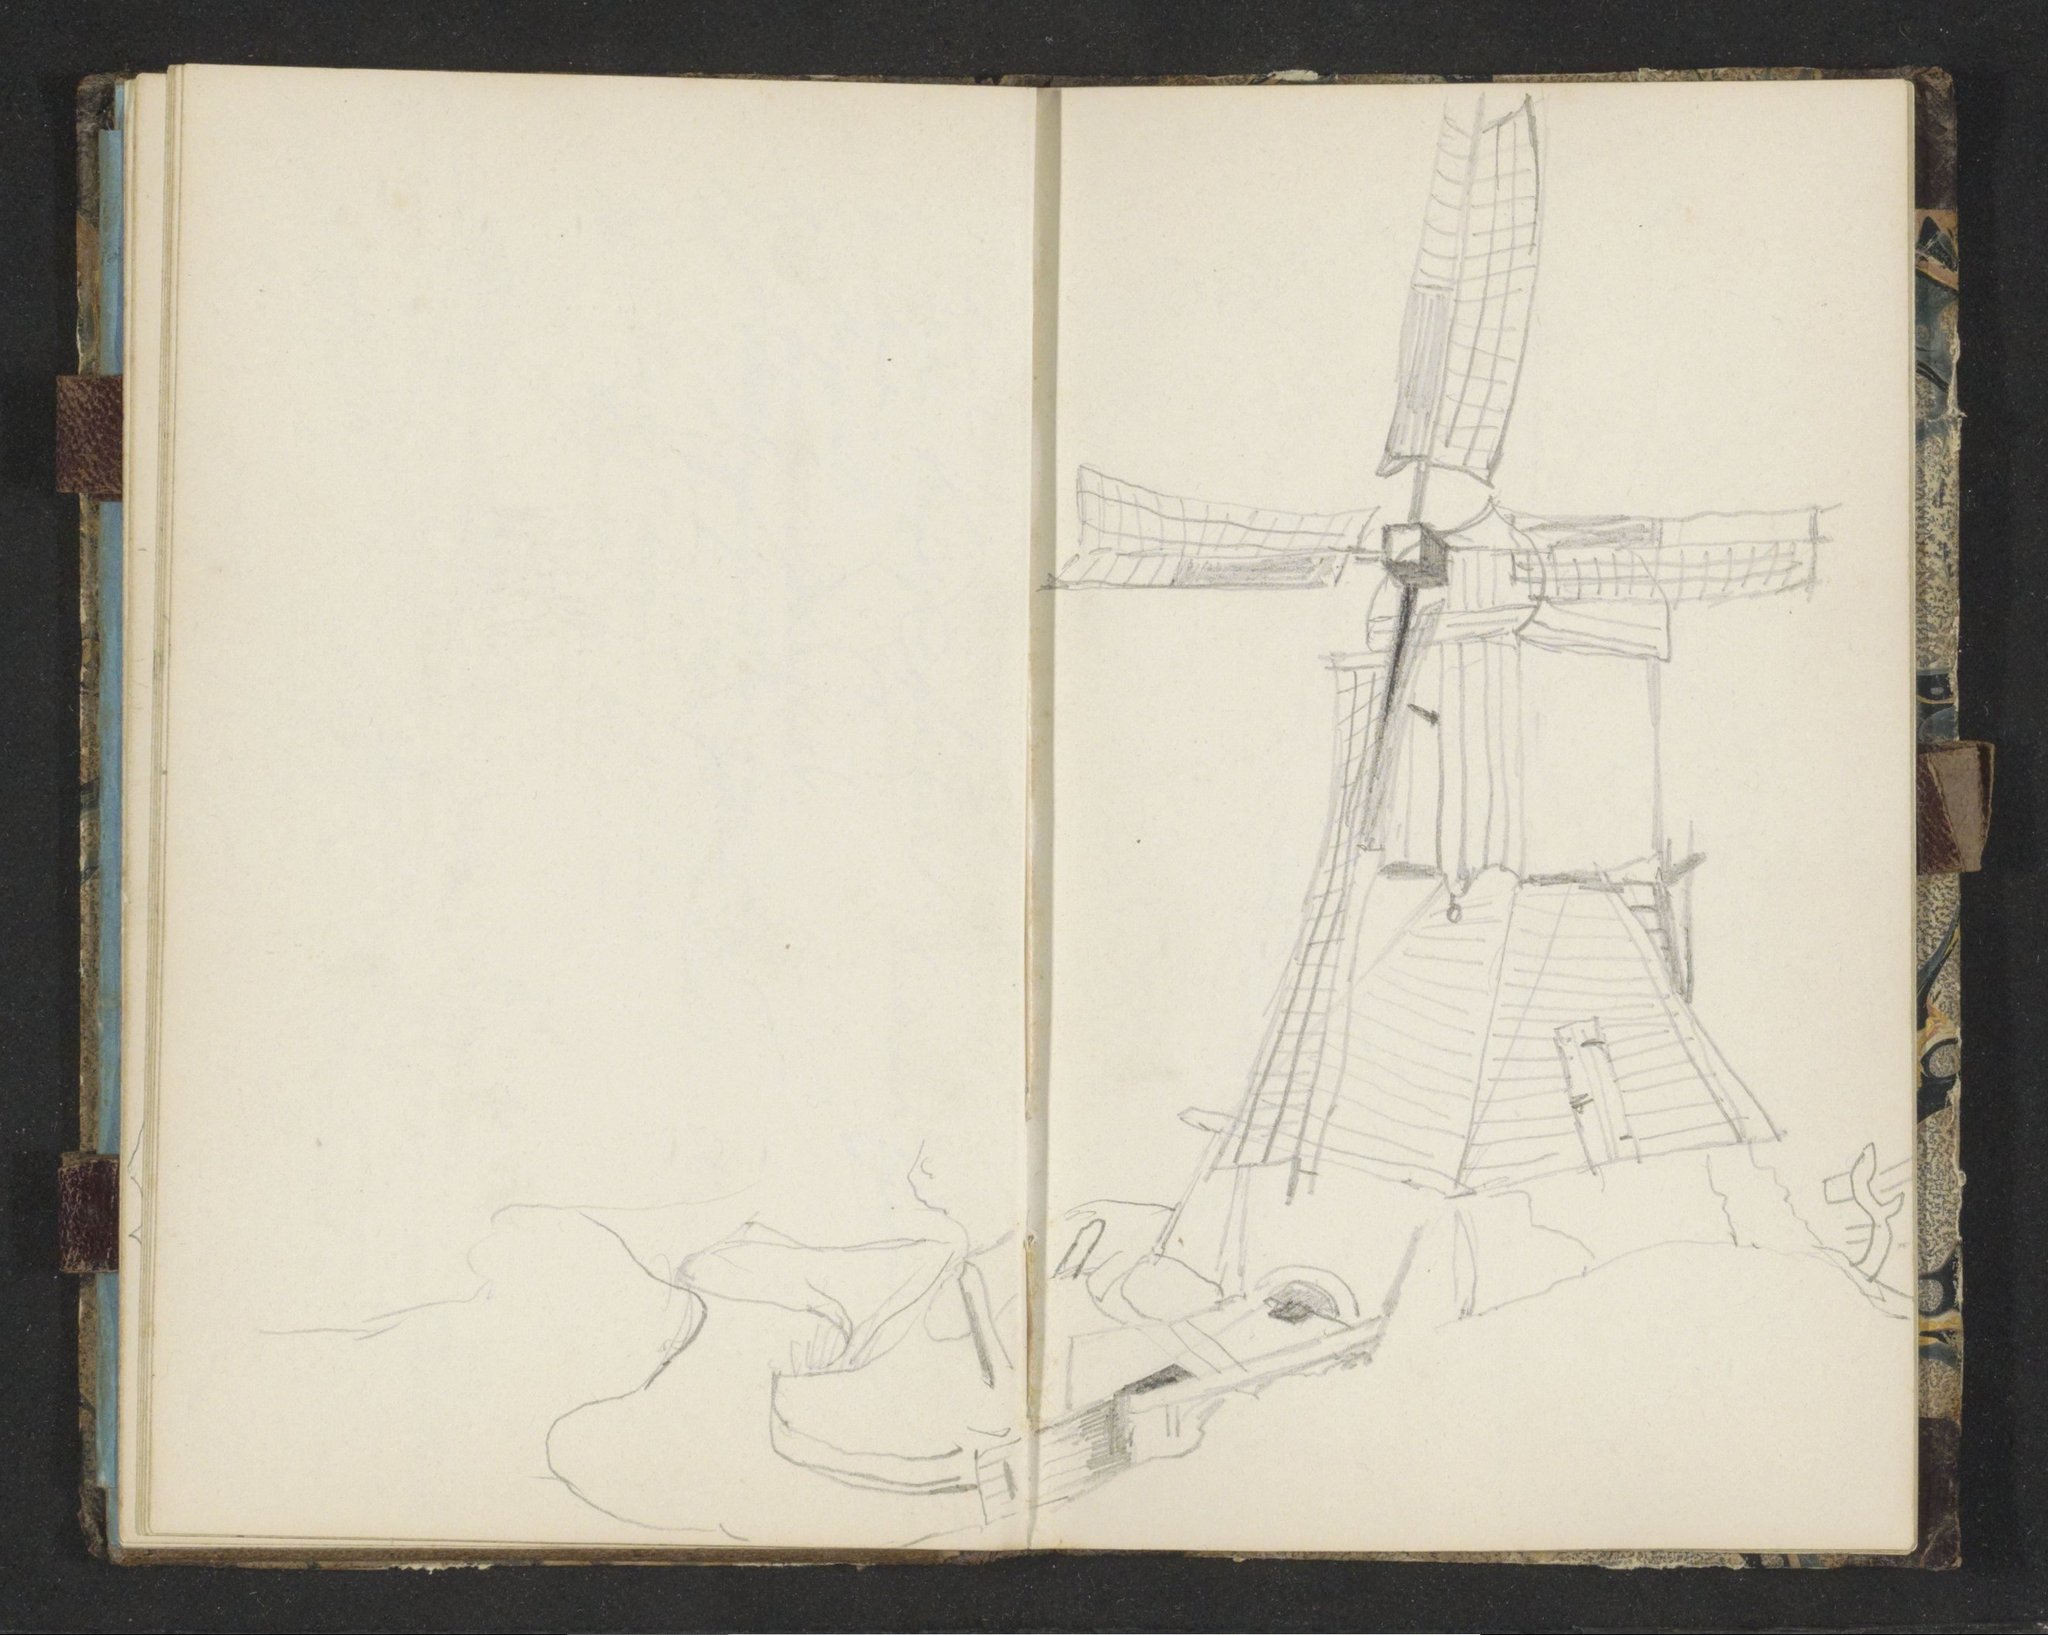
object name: sketchbook leaf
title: Molen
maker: Anonymous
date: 1802-1874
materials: paper, pencil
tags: windmill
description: Blad 9 verso en 10 recto uit een schetsboek met 19 bladen.